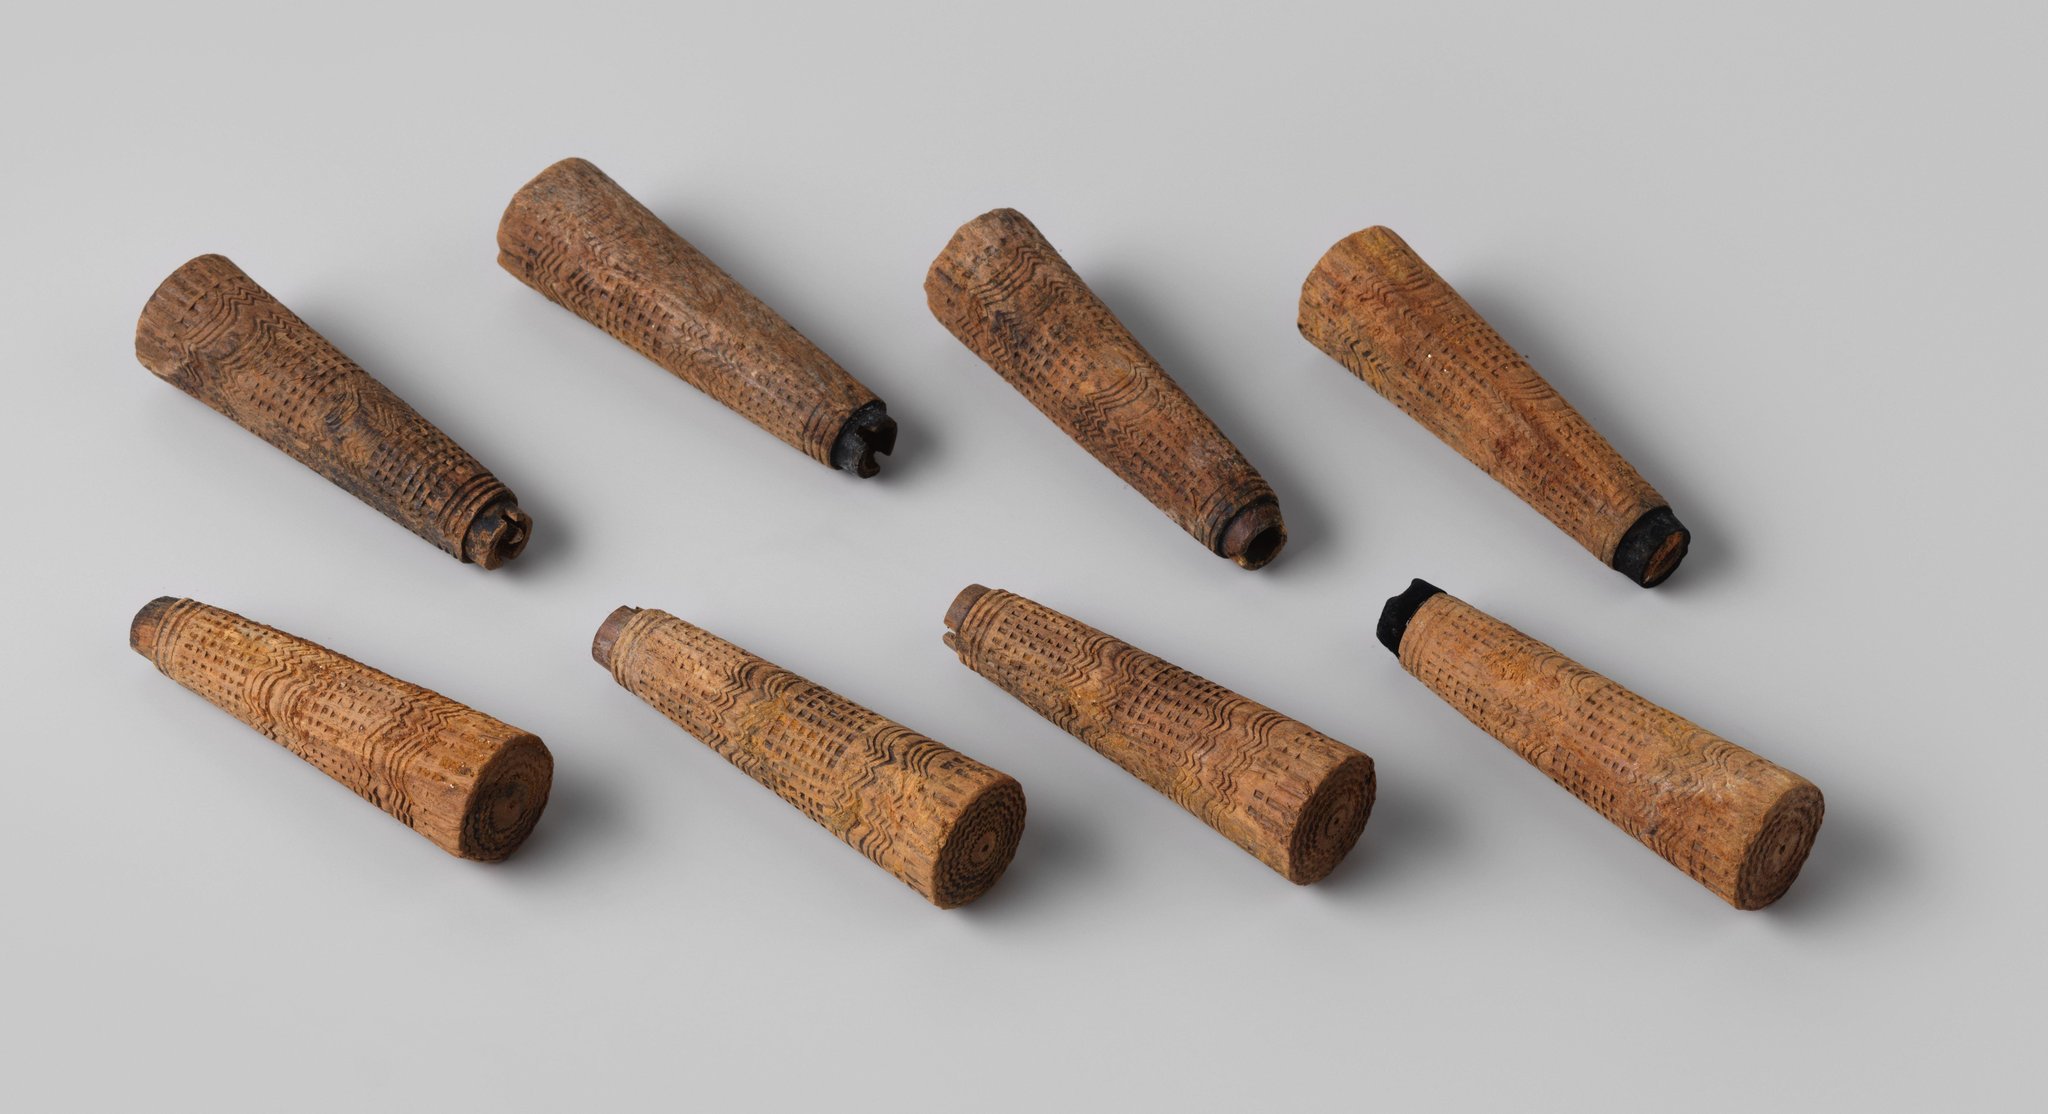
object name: knife handle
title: Messenheften uit het wrak van de Oost-Indiëvaarder Hollandia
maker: Anonymous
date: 1700-1743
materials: copper, wood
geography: netherlands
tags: verenigde oostindische compagnie, hollandia (schip), annet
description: Knife, handle, cylindrical: tapering; id. NG 1979-403H, ferrules, id. NG 1980-27H426.